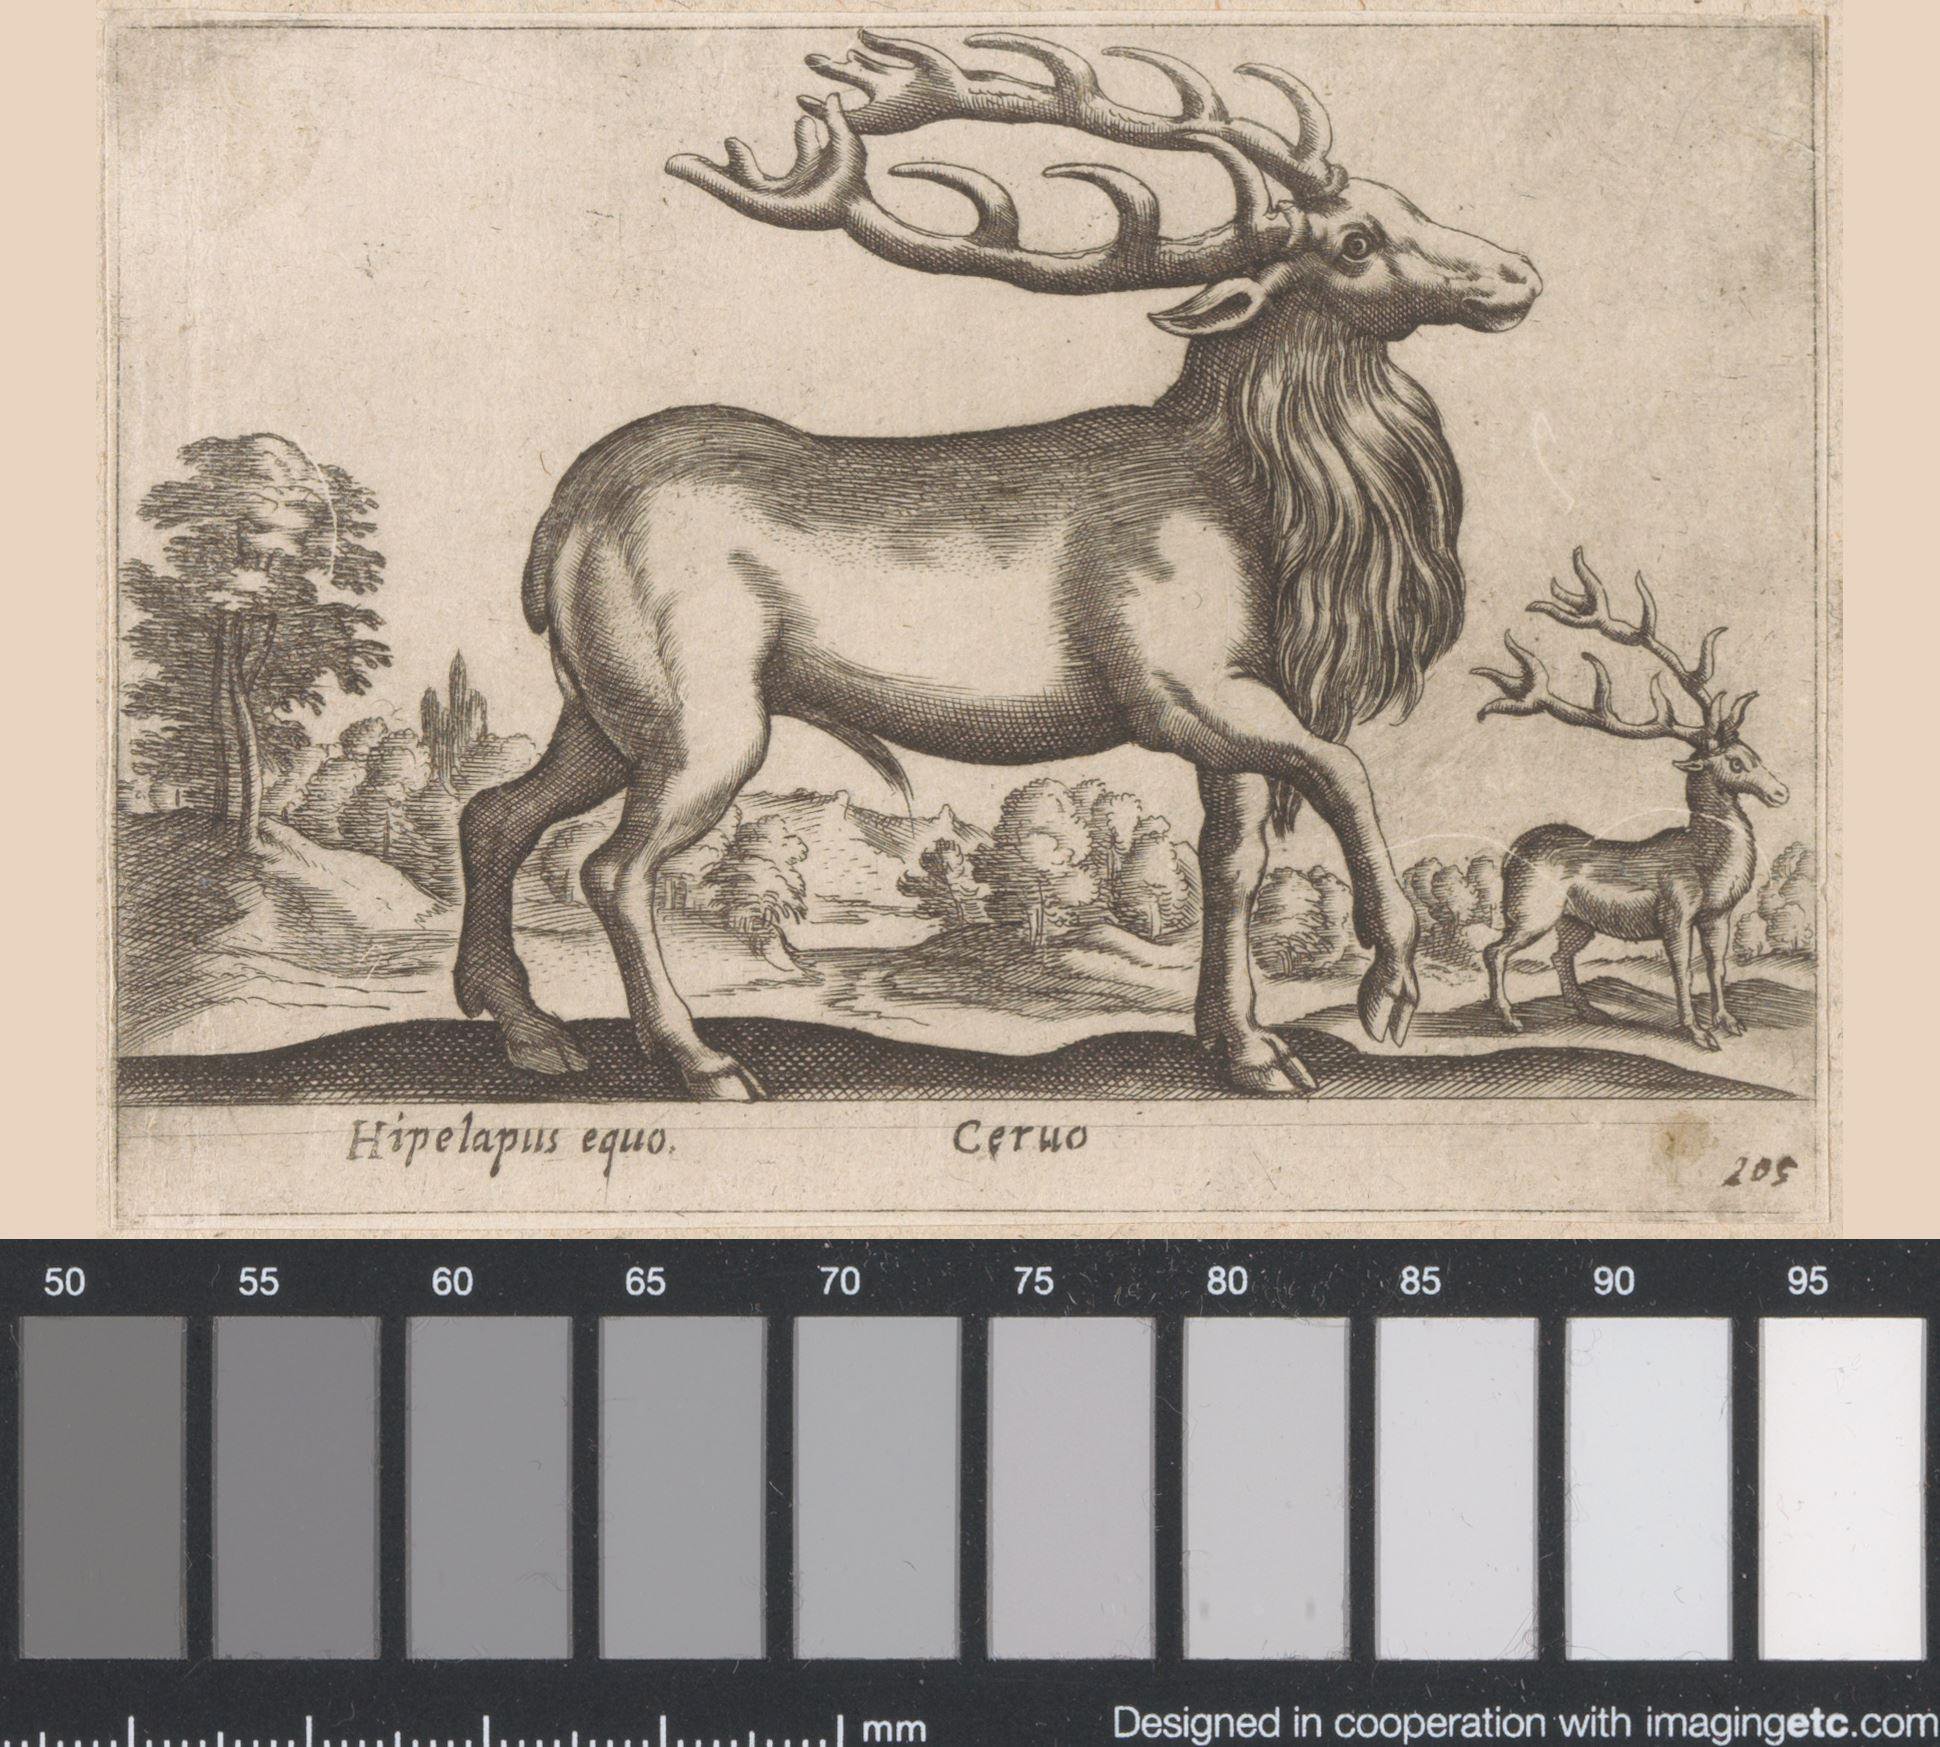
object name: print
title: Dieren en fabelwezens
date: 1565-1630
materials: paper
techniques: etching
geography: vatican city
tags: hoofed animals: stag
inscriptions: number: ‘205’, collector's mark: Lugt 11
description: Deze prent maakt deel uit van een reeks prenten van dieren door Antonio Tempesta. Bekend is dat een tweede staat (met nummering) van deze serie is uitgegeven door Giovanni Giacomo de' Rossi in 1650. Onbekend is wie de eerste staat heeft uitgegeven en wanneer.